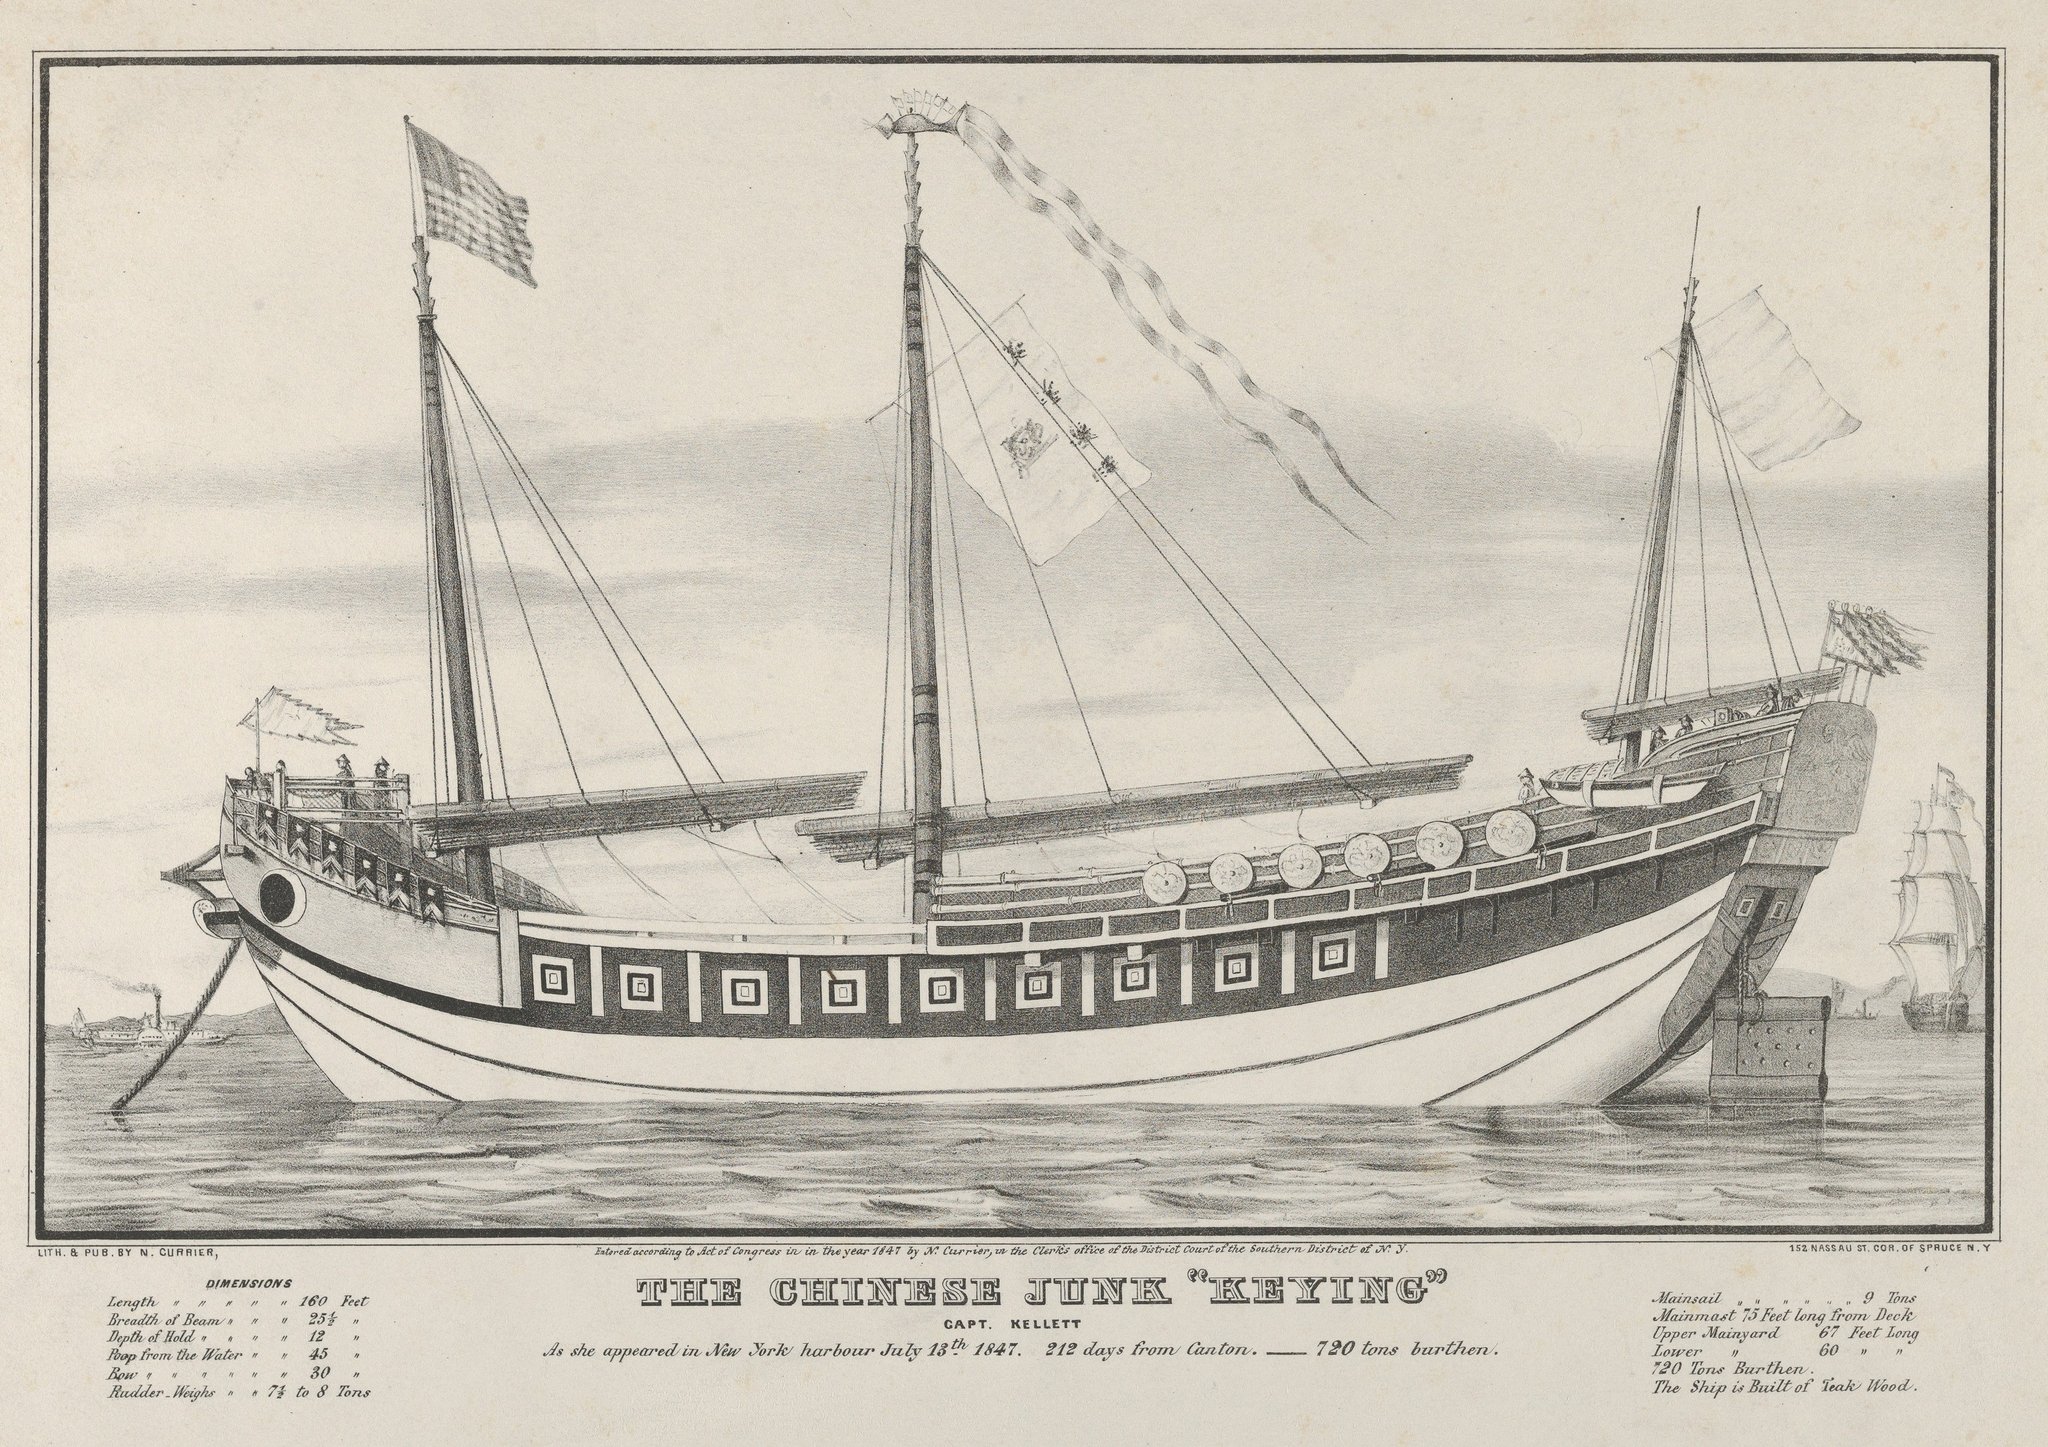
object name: print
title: The Chinese Junk "Keying"–Captain Kellett–As she appeared in New York harbour July 13th, 1847–212 days from Canton.–720 tons burthen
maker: nathaniel currier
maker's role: lithographer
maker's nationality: american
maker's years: 1813-1888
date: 1847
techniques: lithograph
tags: ships